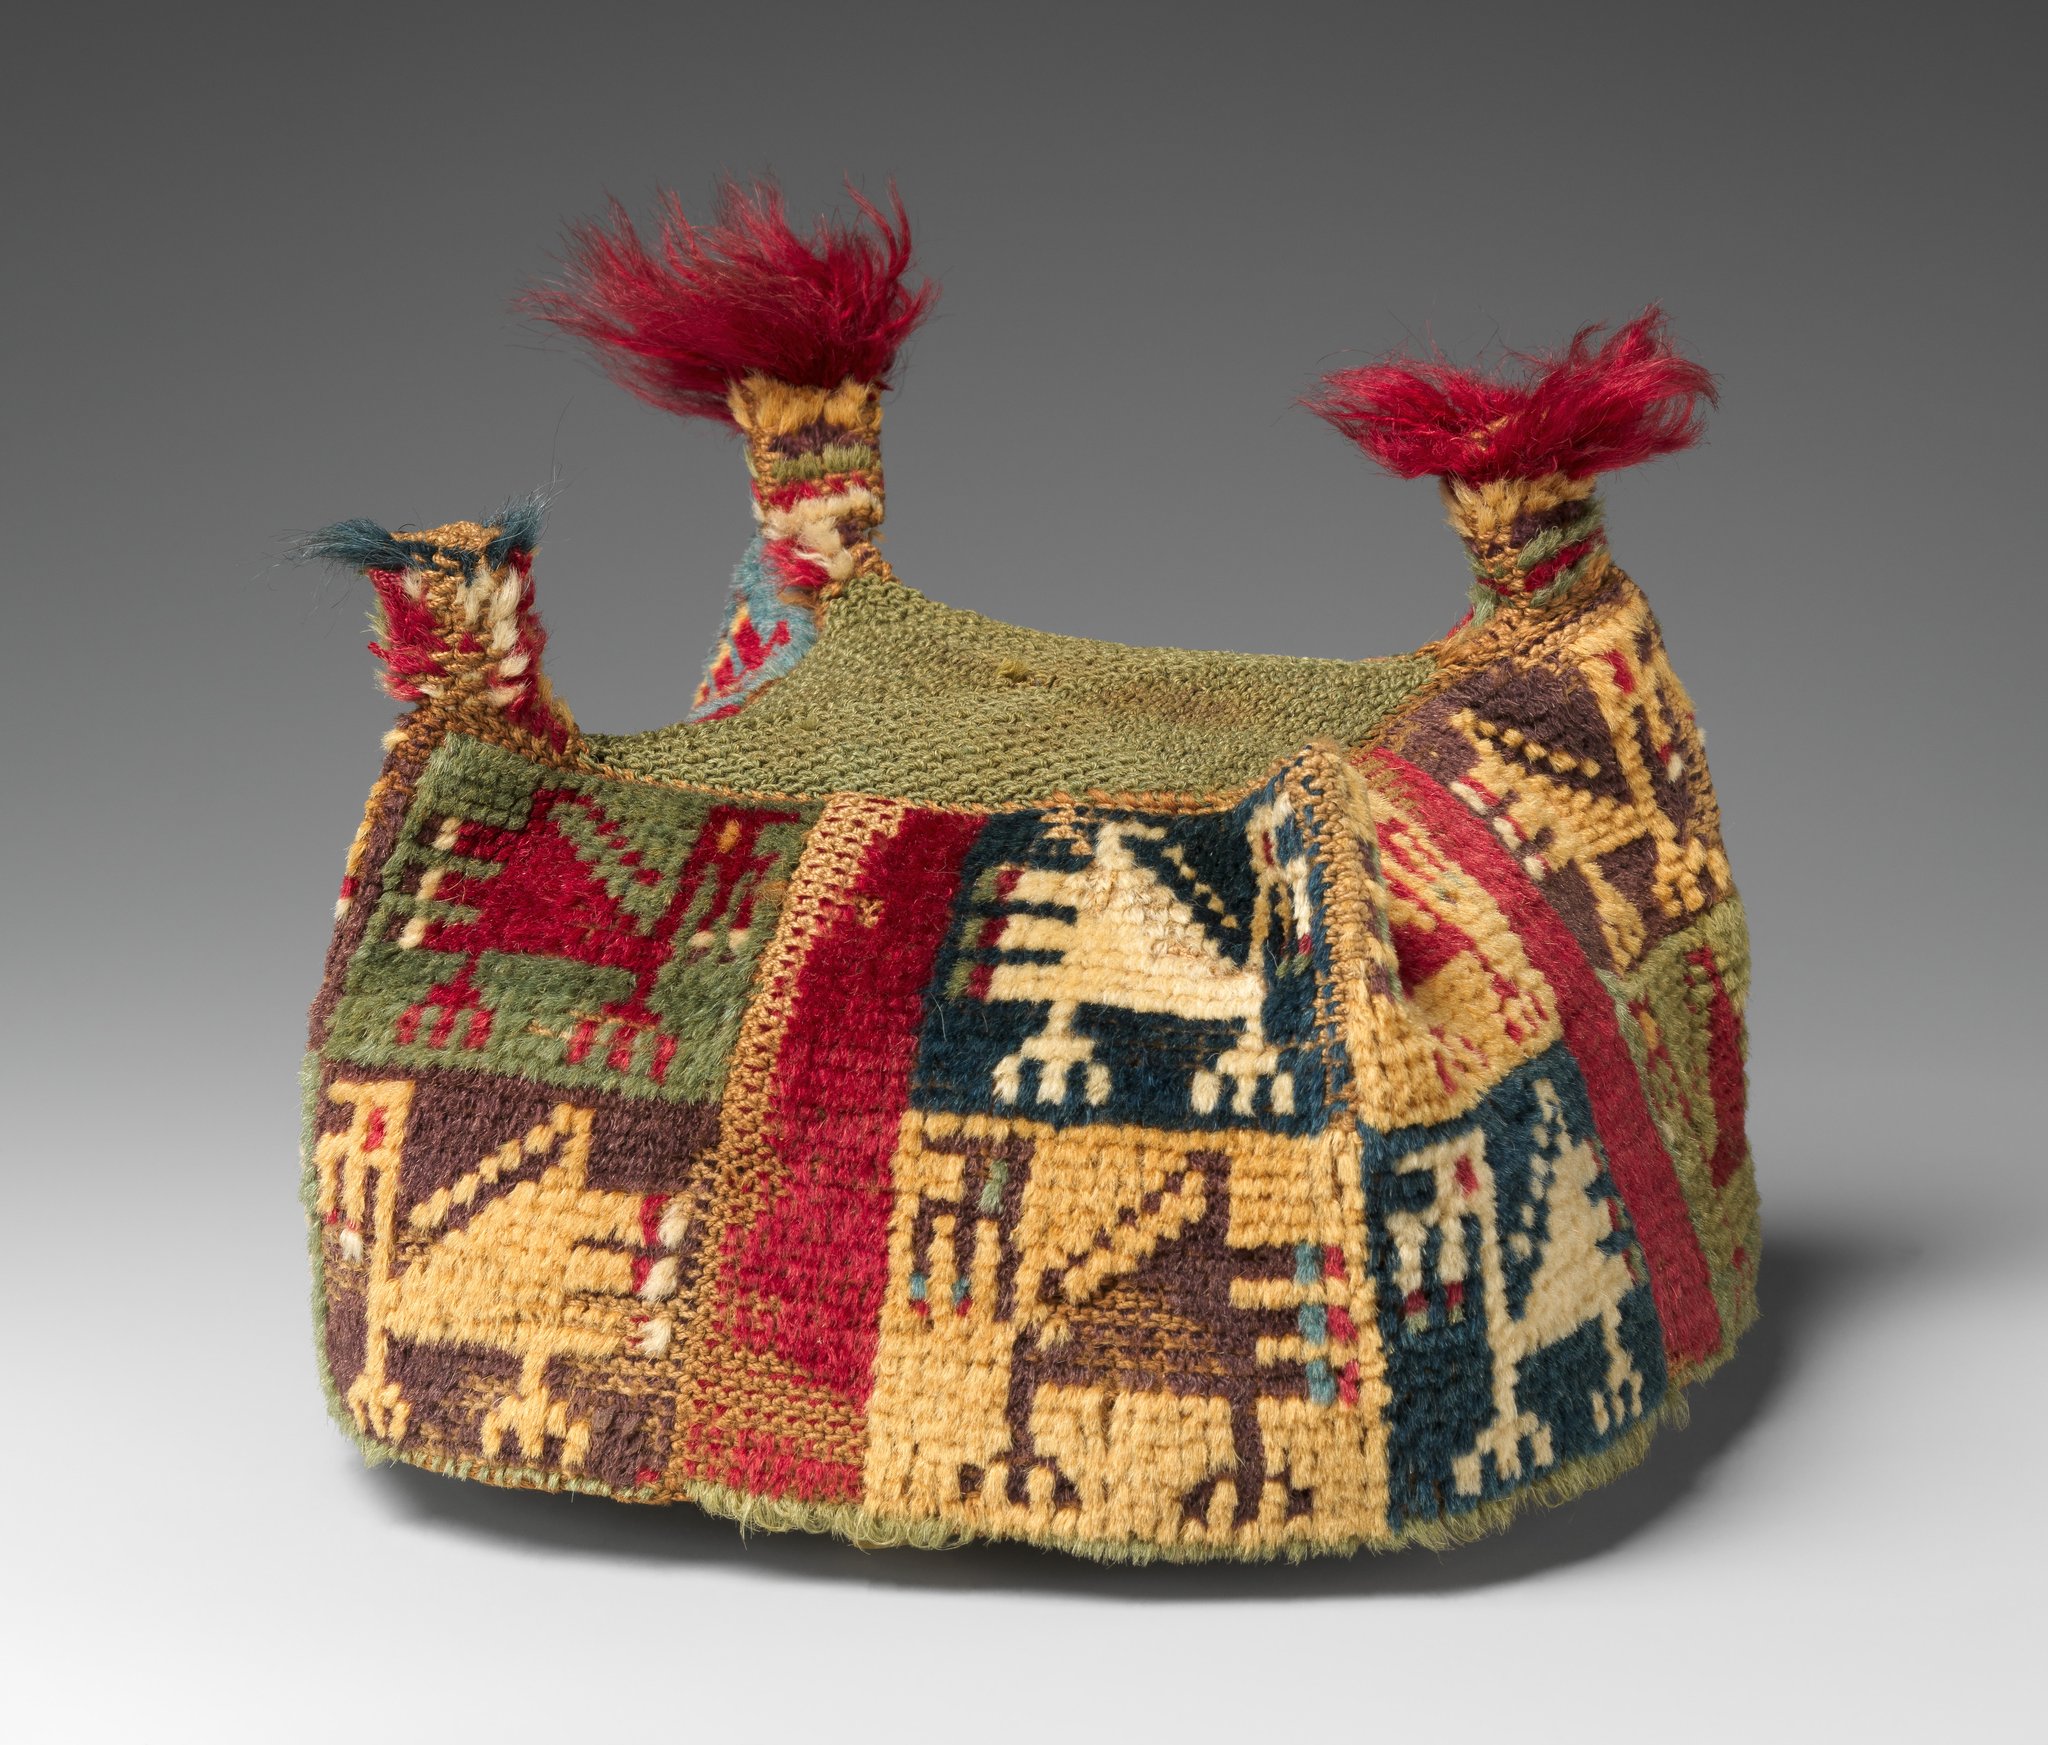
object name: hat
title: Four-Cornered Hat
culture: wari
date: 601-900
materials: animal fiber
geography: peru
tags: birds